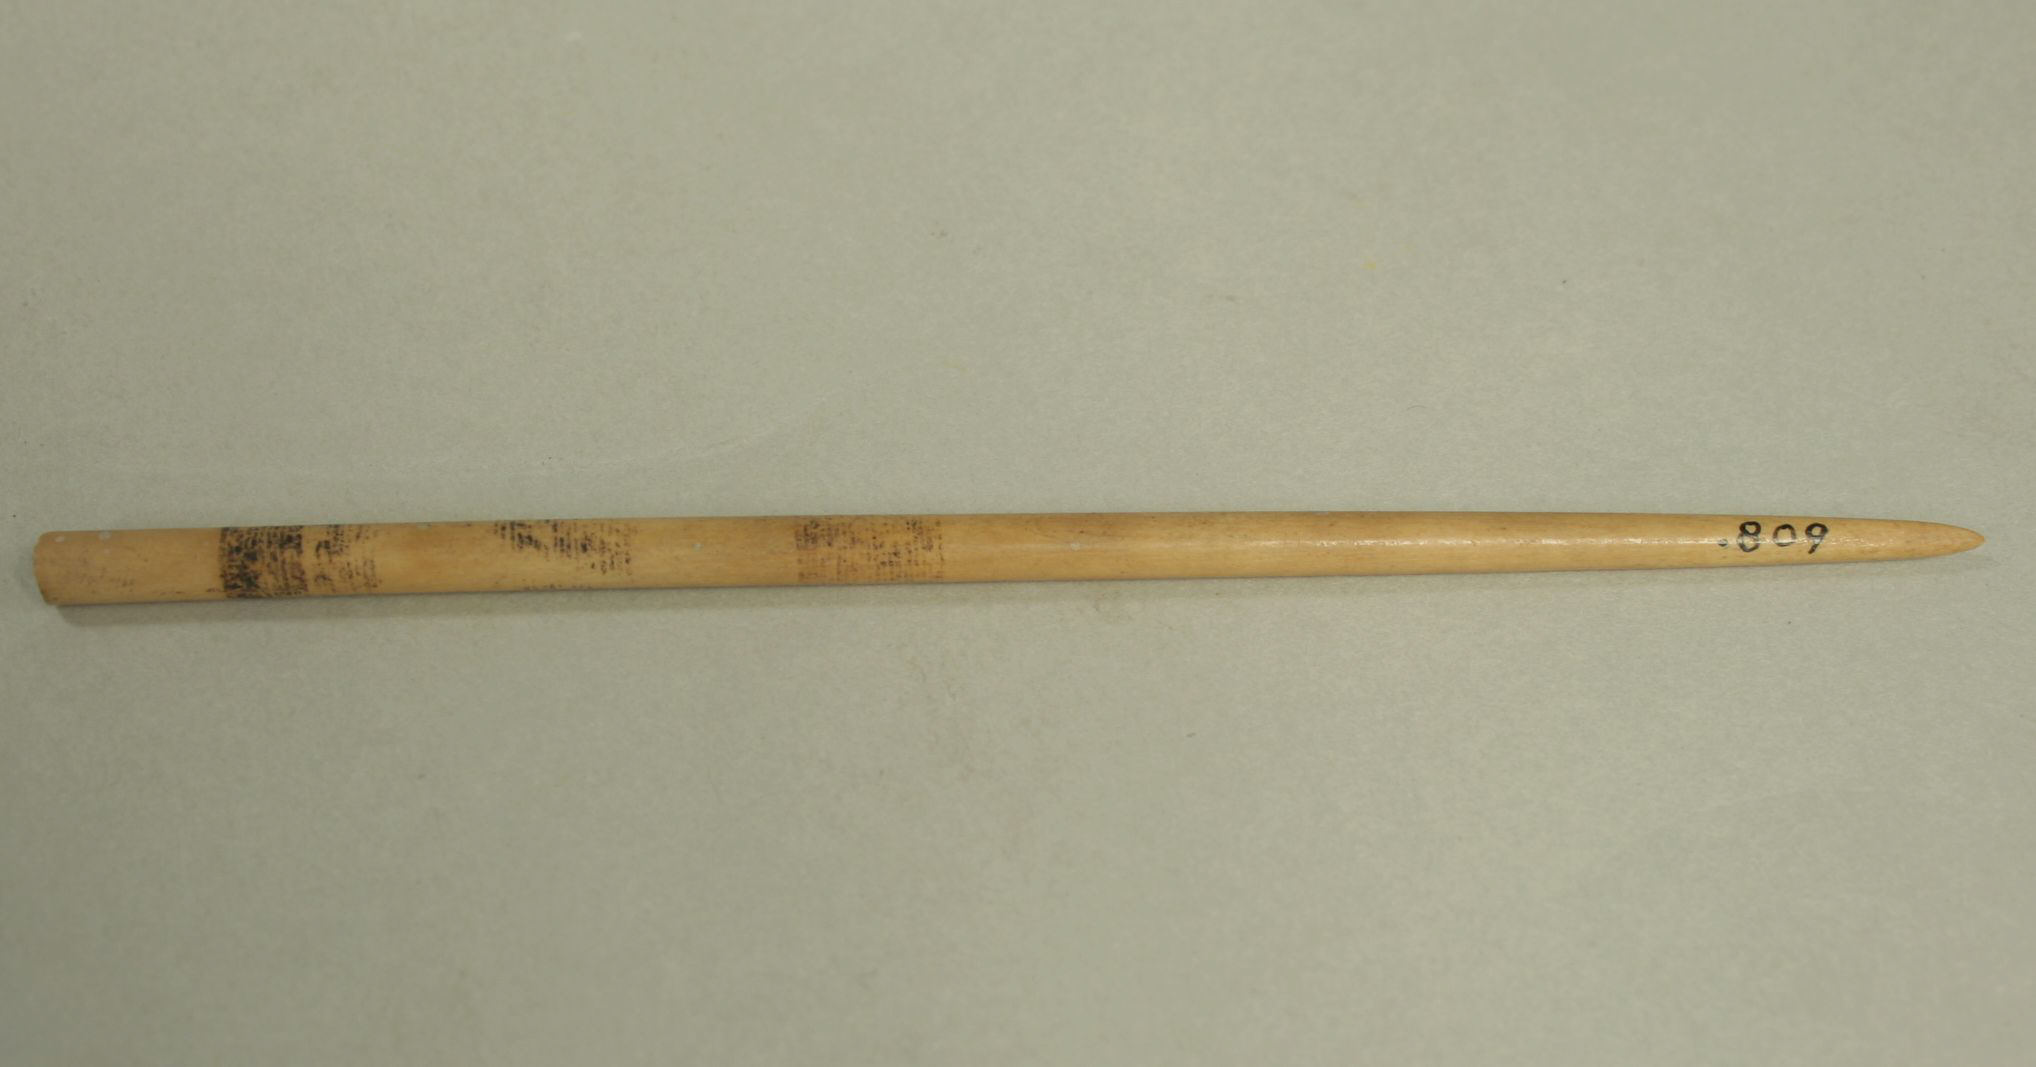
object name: bobbin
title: Bone Weaving Bobbin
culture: peruvian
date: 701-1566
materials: bone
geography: peru